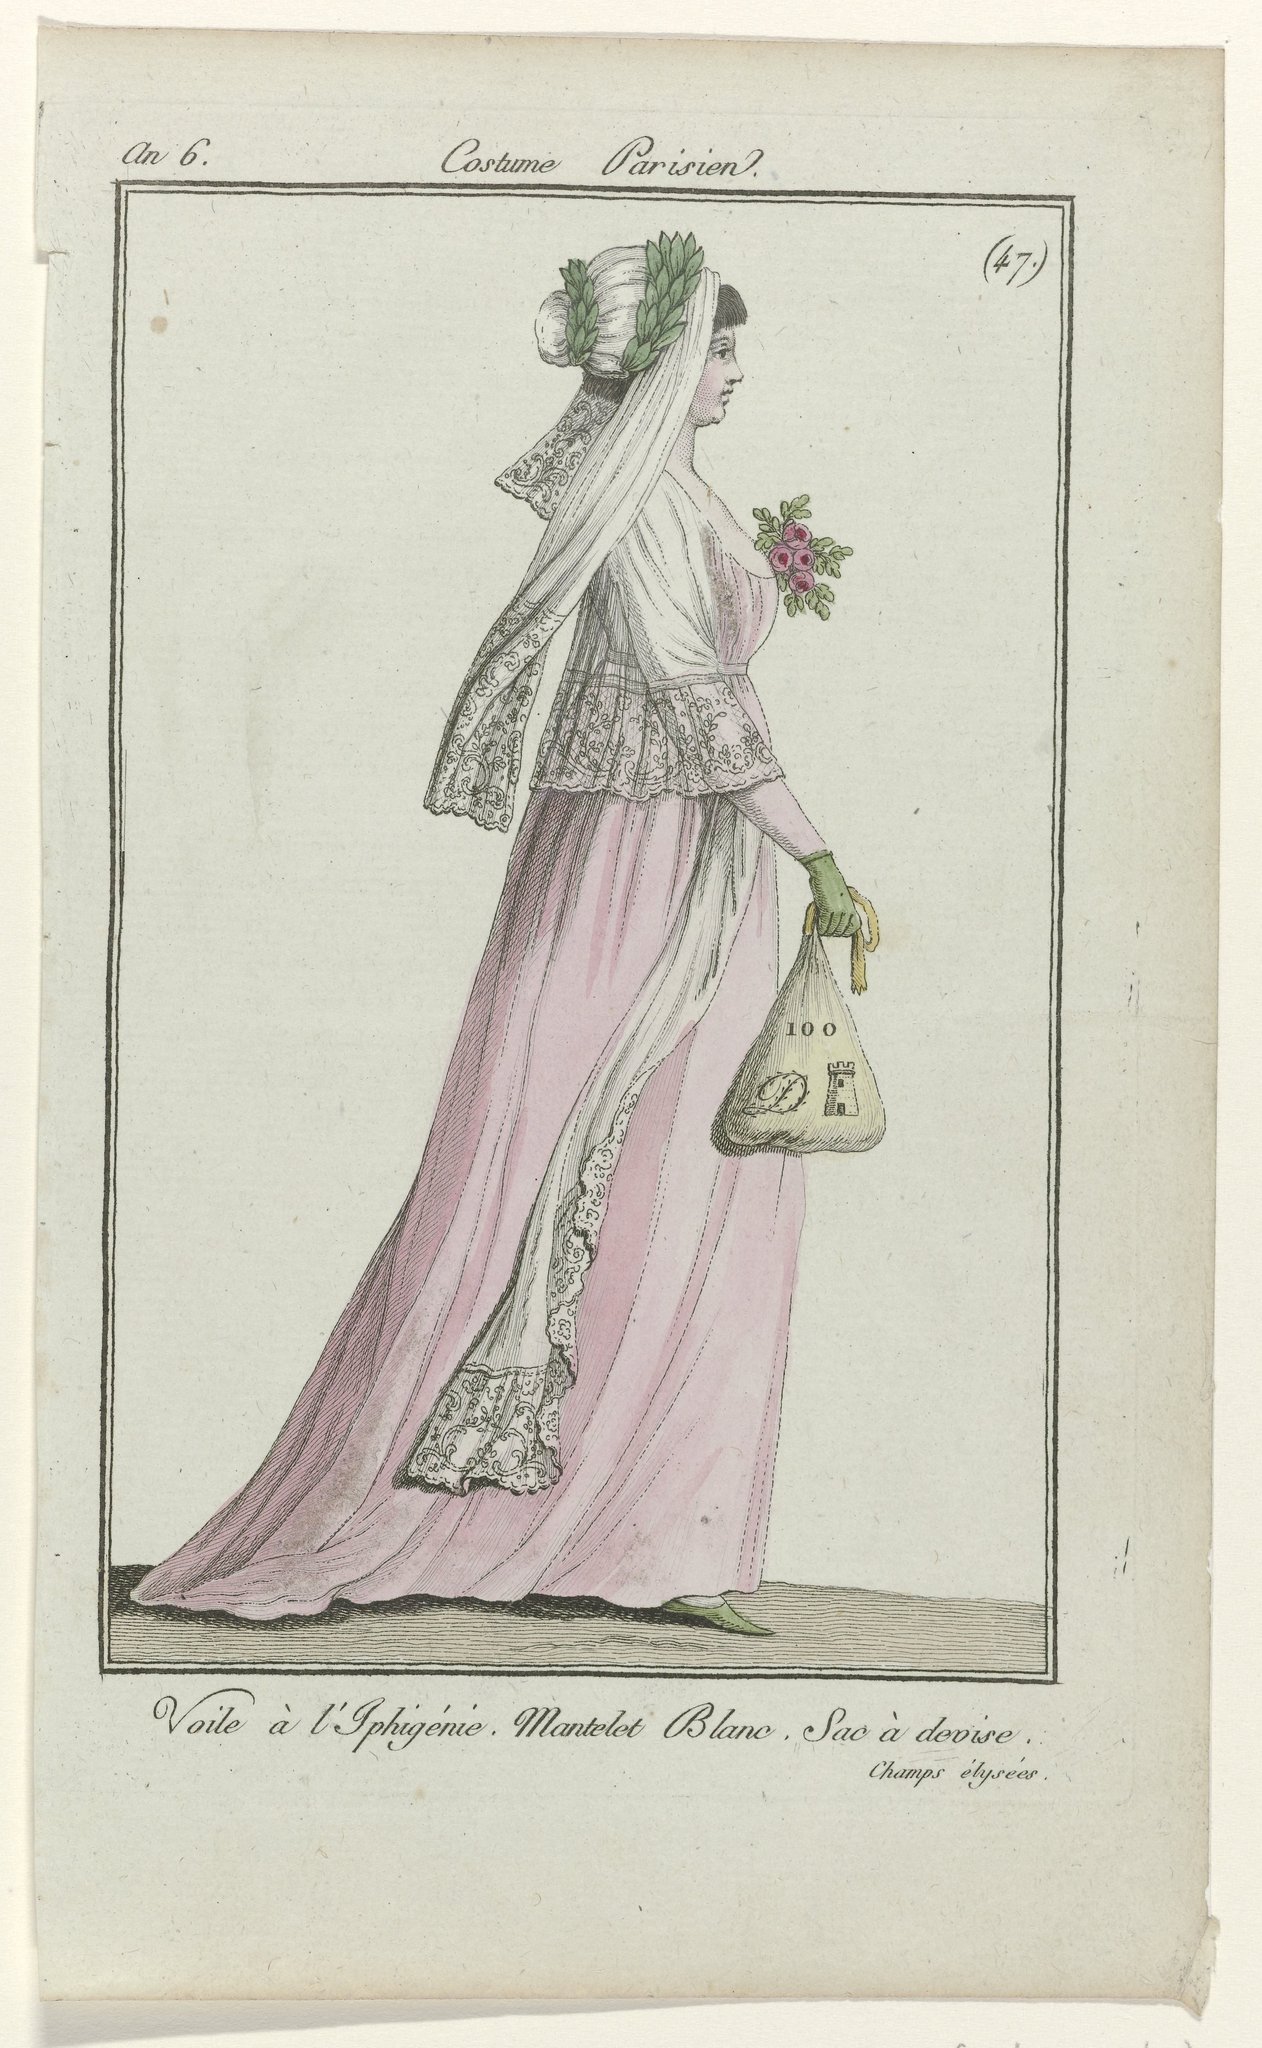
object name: fashion print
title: Journal des Dames et des Modes, Costume Parisien, 3 juillet 1798, An 6, (47) : Voile à l'Iphigénie (...)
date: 1798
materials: paper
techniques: engraving, hand coloring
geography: paris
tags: corsage (+ women's clothes), cut flowers; nosegay, bunch of flowers, veil (+ women's clothes), bag (handbag) (+ women's clothes), head-gear (+ women's clothes), fashion plates, gloves, mittens, etc. (+ women's clothes), dress, gown (+ women's clothes)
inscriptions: caption: ‘Voile à l'Iphigénie. Mantelet Blanc. Sac à devise. / Champs élysées.’, title: ‘Costume Parisien.’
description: Sluier met de naam 'Voile à l'Iphigénie'. Kleine witte schoudermantel op een japon met sleep. In de rechterhand een tas of 'sac' met devies. Verdere accessoires: bloemcorsage, handschoen, platte schoen met puntige neus. Volgens het onderschrift is deze voorstelling naar het leven getekend op de 'Champs Élysées'. De prent maakt deel uit van het modetijdschrift Journal des Dames et des Modes, uitgegeven door Sellèque, Parijs, 1797-1839.